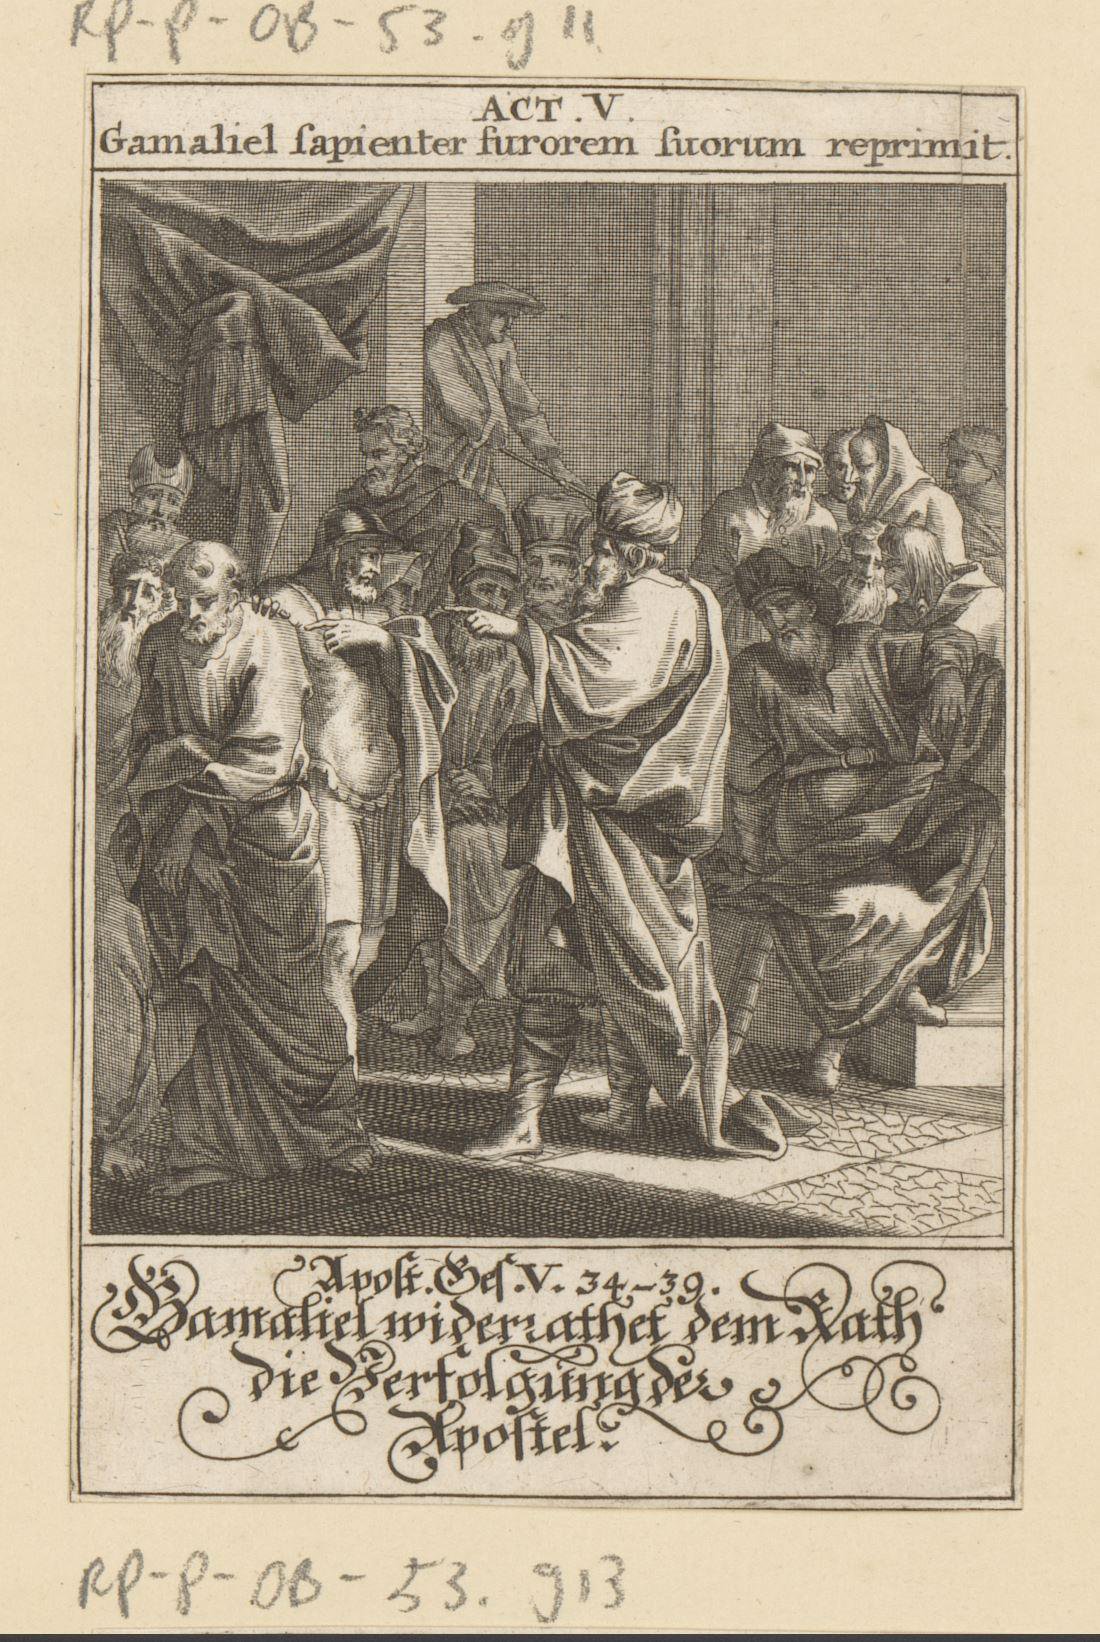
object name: print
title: Gamaliël raadt de vervolging van de apostelen af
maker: Anonymous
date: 1697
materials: paper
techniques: etching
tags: the warning of gamaliel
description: Prent ook gebruikt in: Biblia ectypa : Bildnussen auss Heiliger Schrifft. Regensburg: Chr. Wiegel, 1697.